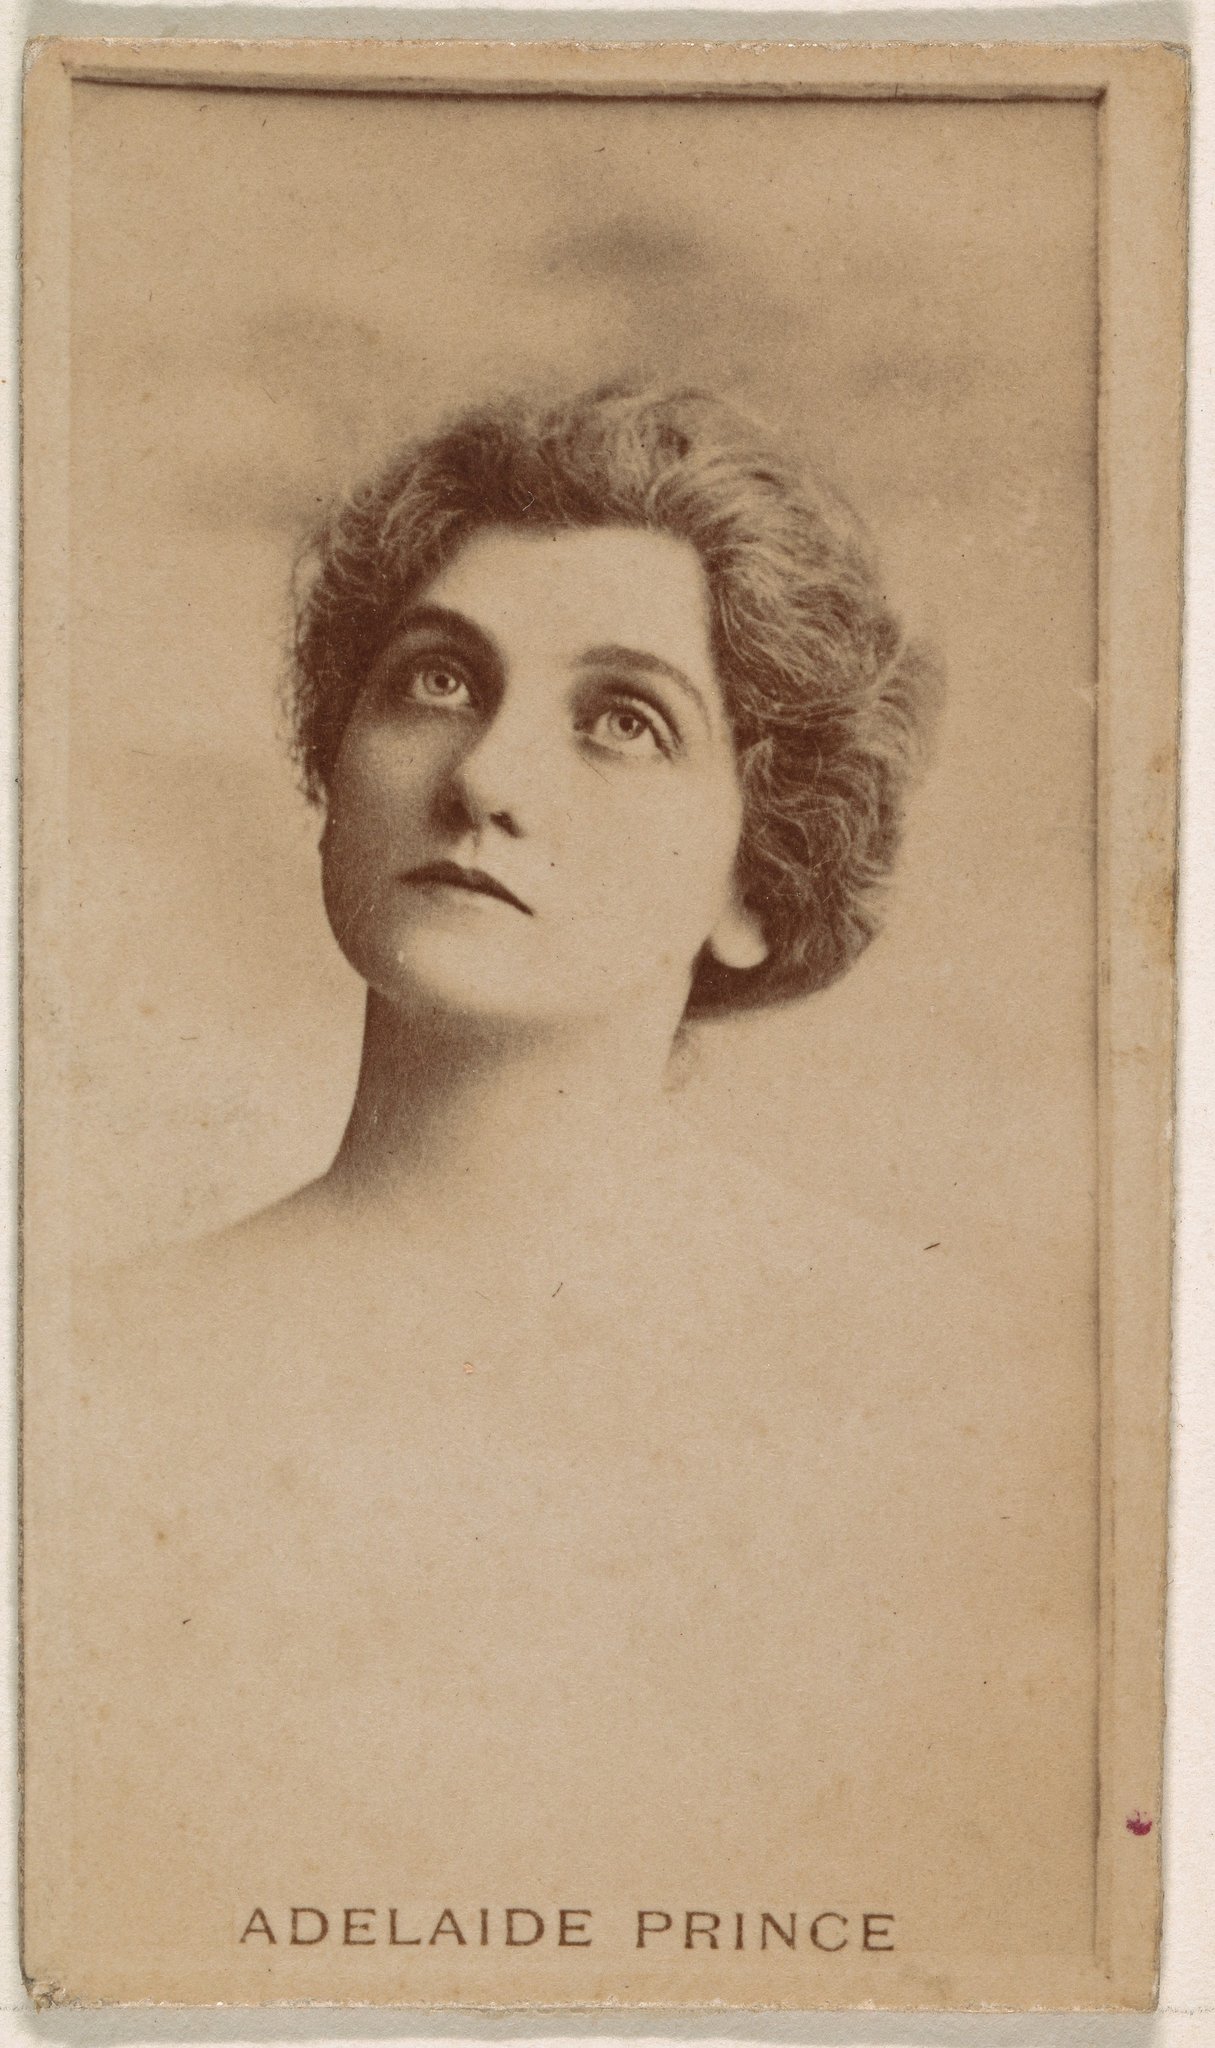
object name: photograph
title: Adelaide Prince, from the Actresses series (N245) issued by Kinney Brothers to promote Sweet Caporal Cigarettes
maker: kinney brothers tobacco company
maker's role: publisher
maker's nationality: american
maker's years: 1869-2011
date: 1890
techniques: albumen silver print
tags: portraits,women,actresses